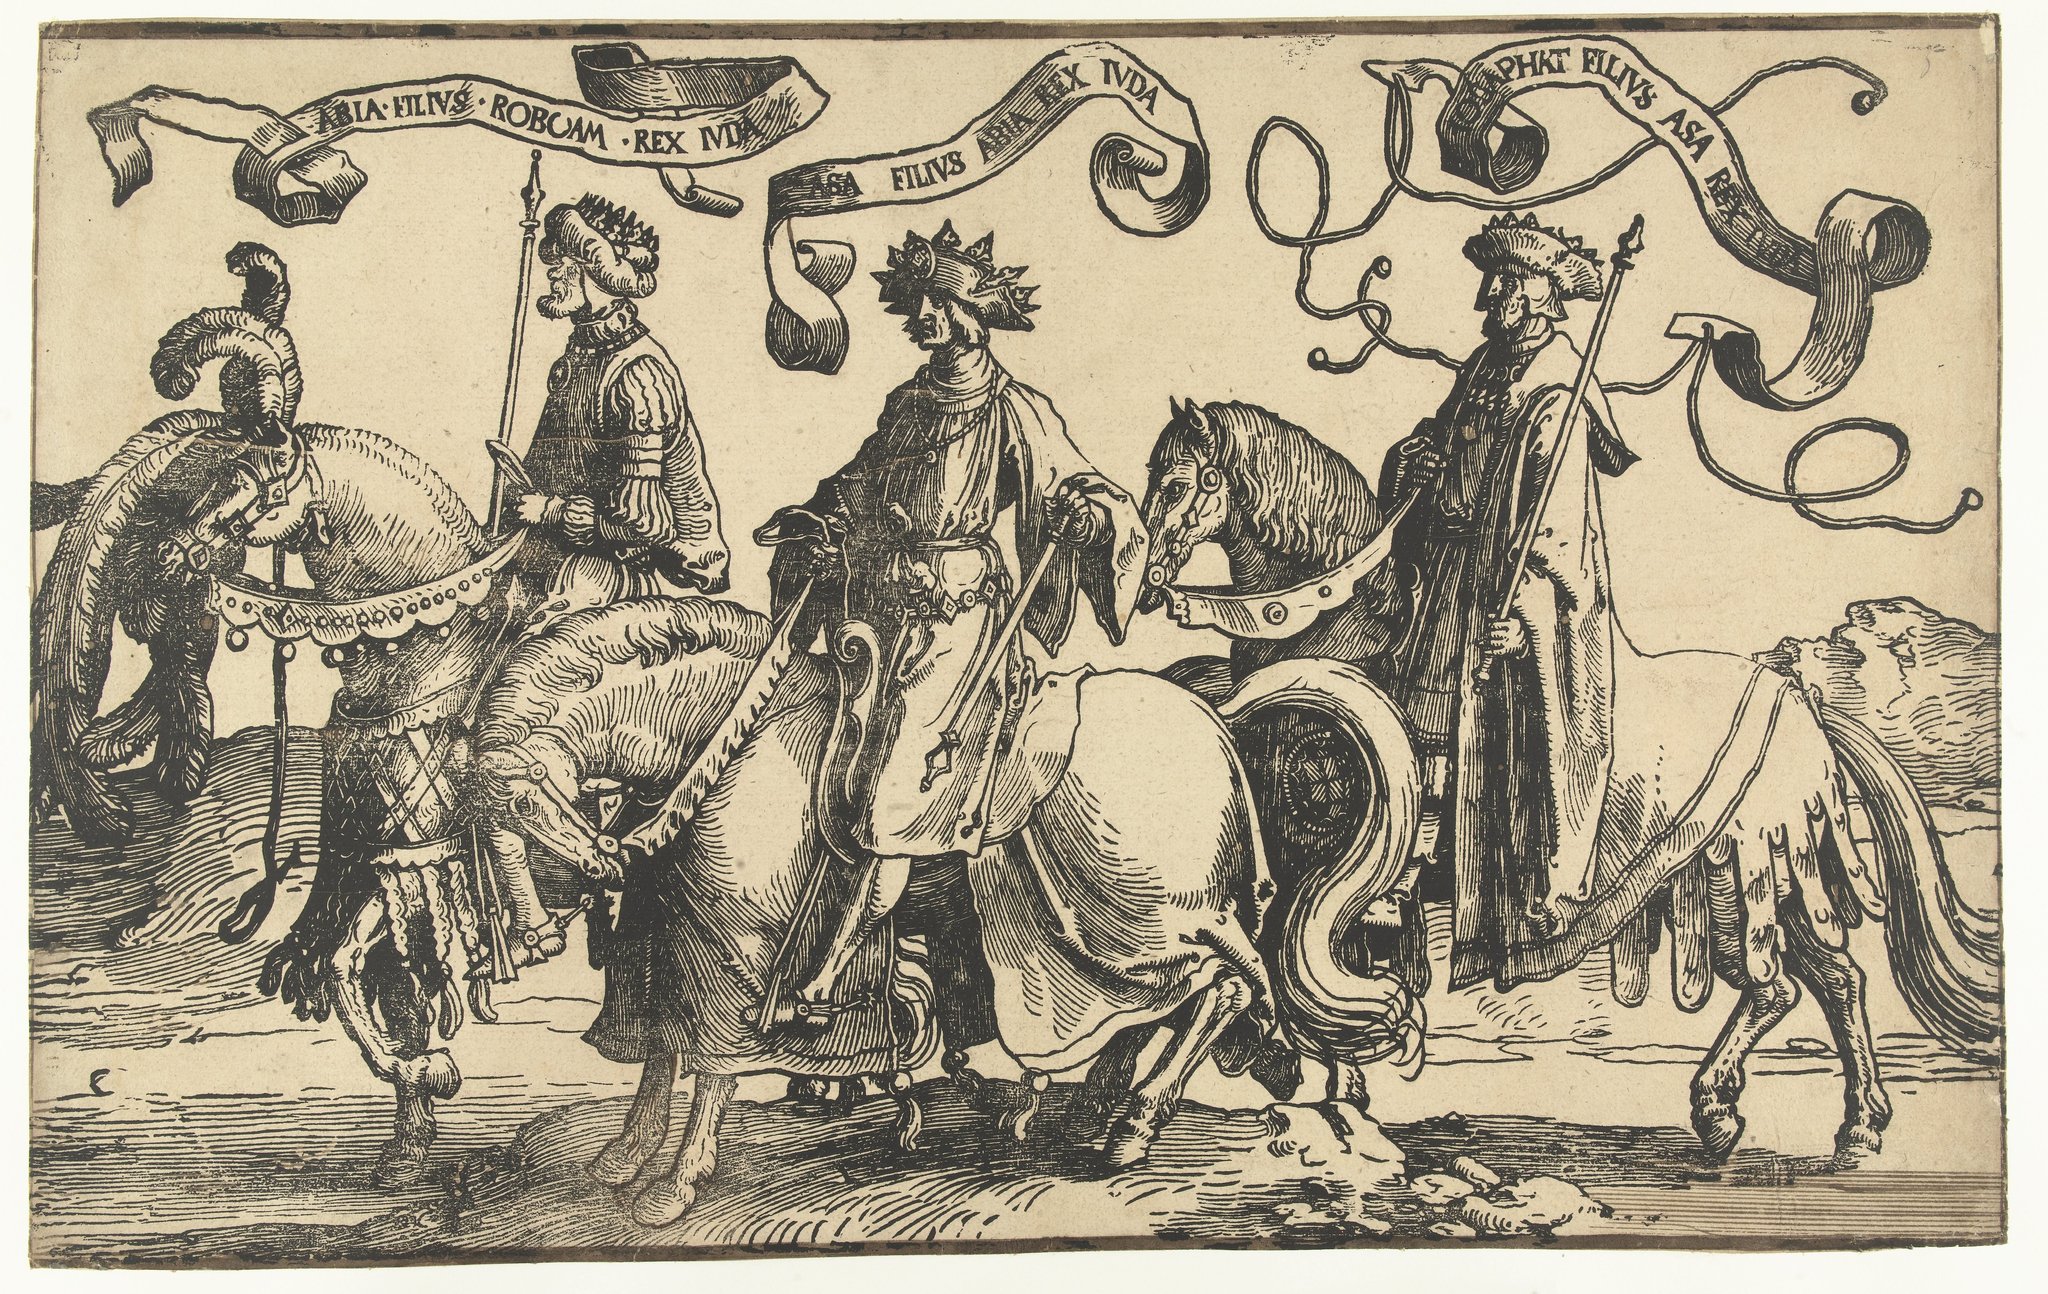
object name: print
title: De twaalf koningen van Israël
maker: lucas van leyden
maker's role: draughtsman, painter, print maker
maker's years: 1494-1533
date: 1518-1522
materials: paper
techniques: brush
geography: low countries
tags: kings of israel and judah ~ the old testament (not in biblical context), male persons from the old testament (with name) (not in biblical context)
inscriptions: collector's mark: Lugt 240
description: Eén van vier houtsneden, onderdeel van fries met koningen van Israël. Abia, Asa en Josafat te paard. Boven alle drie banderol met naam en toenaam.